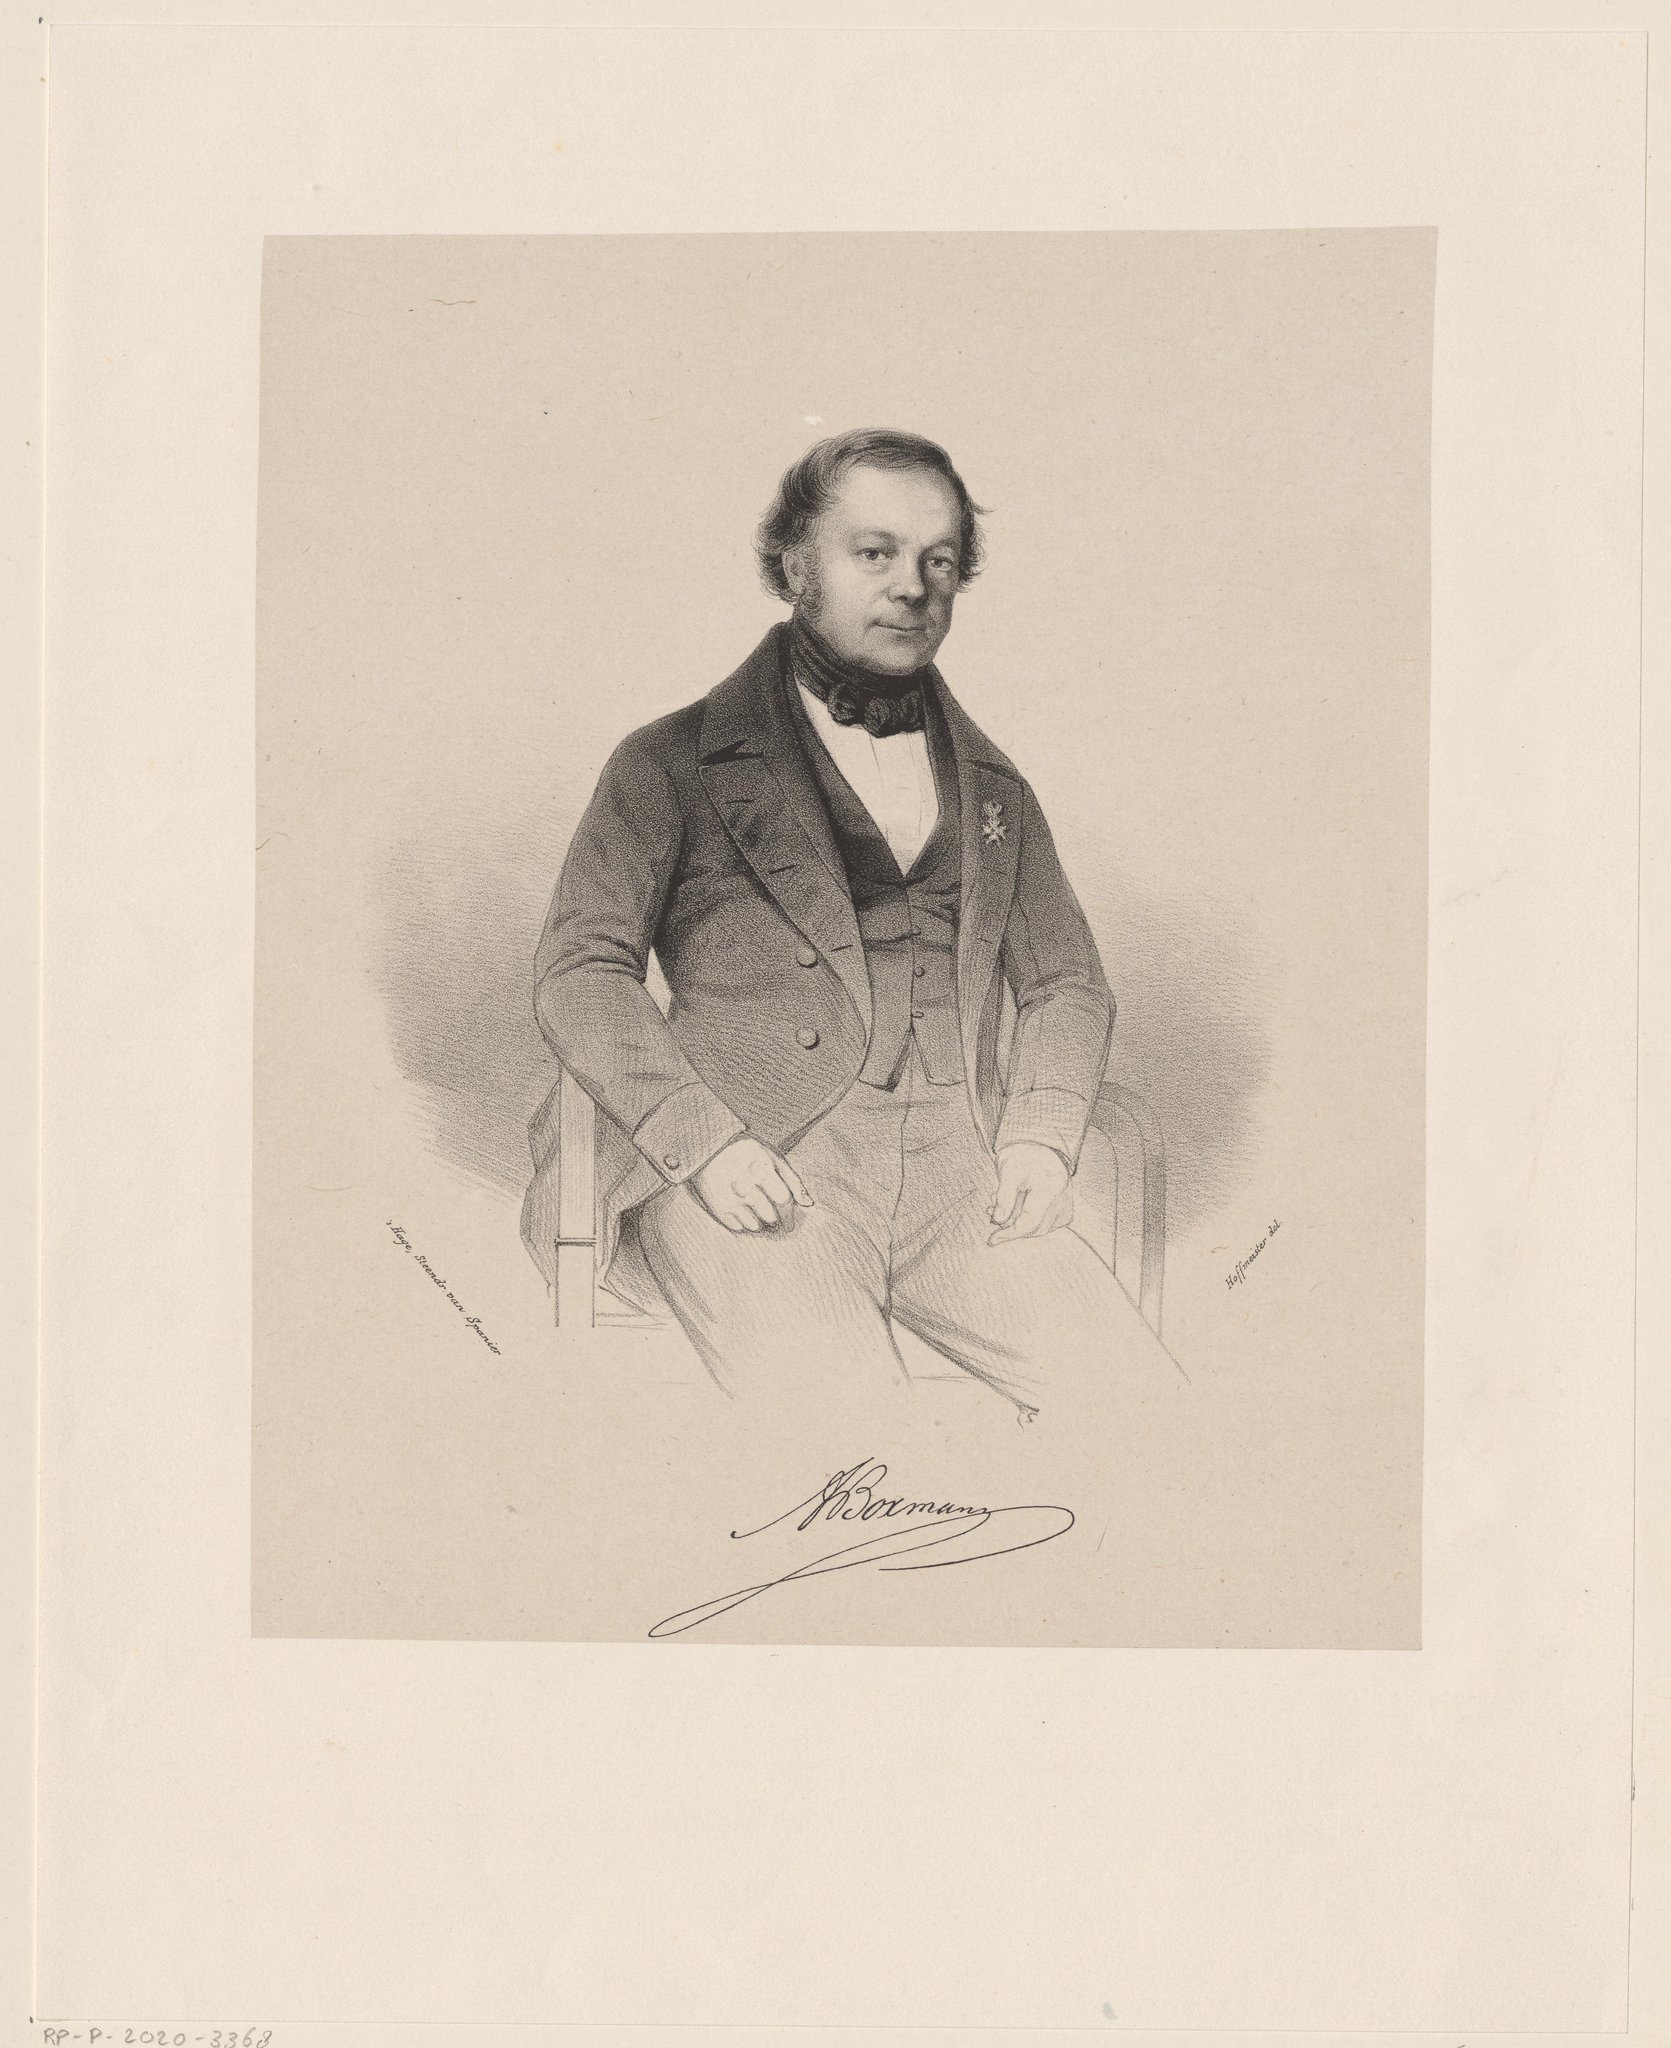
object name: print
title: Portret van Abraham Boxman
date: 1843-1863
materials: paper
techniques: lithograph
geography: the hague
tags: mayor, mayor, burgomaster, historical persons